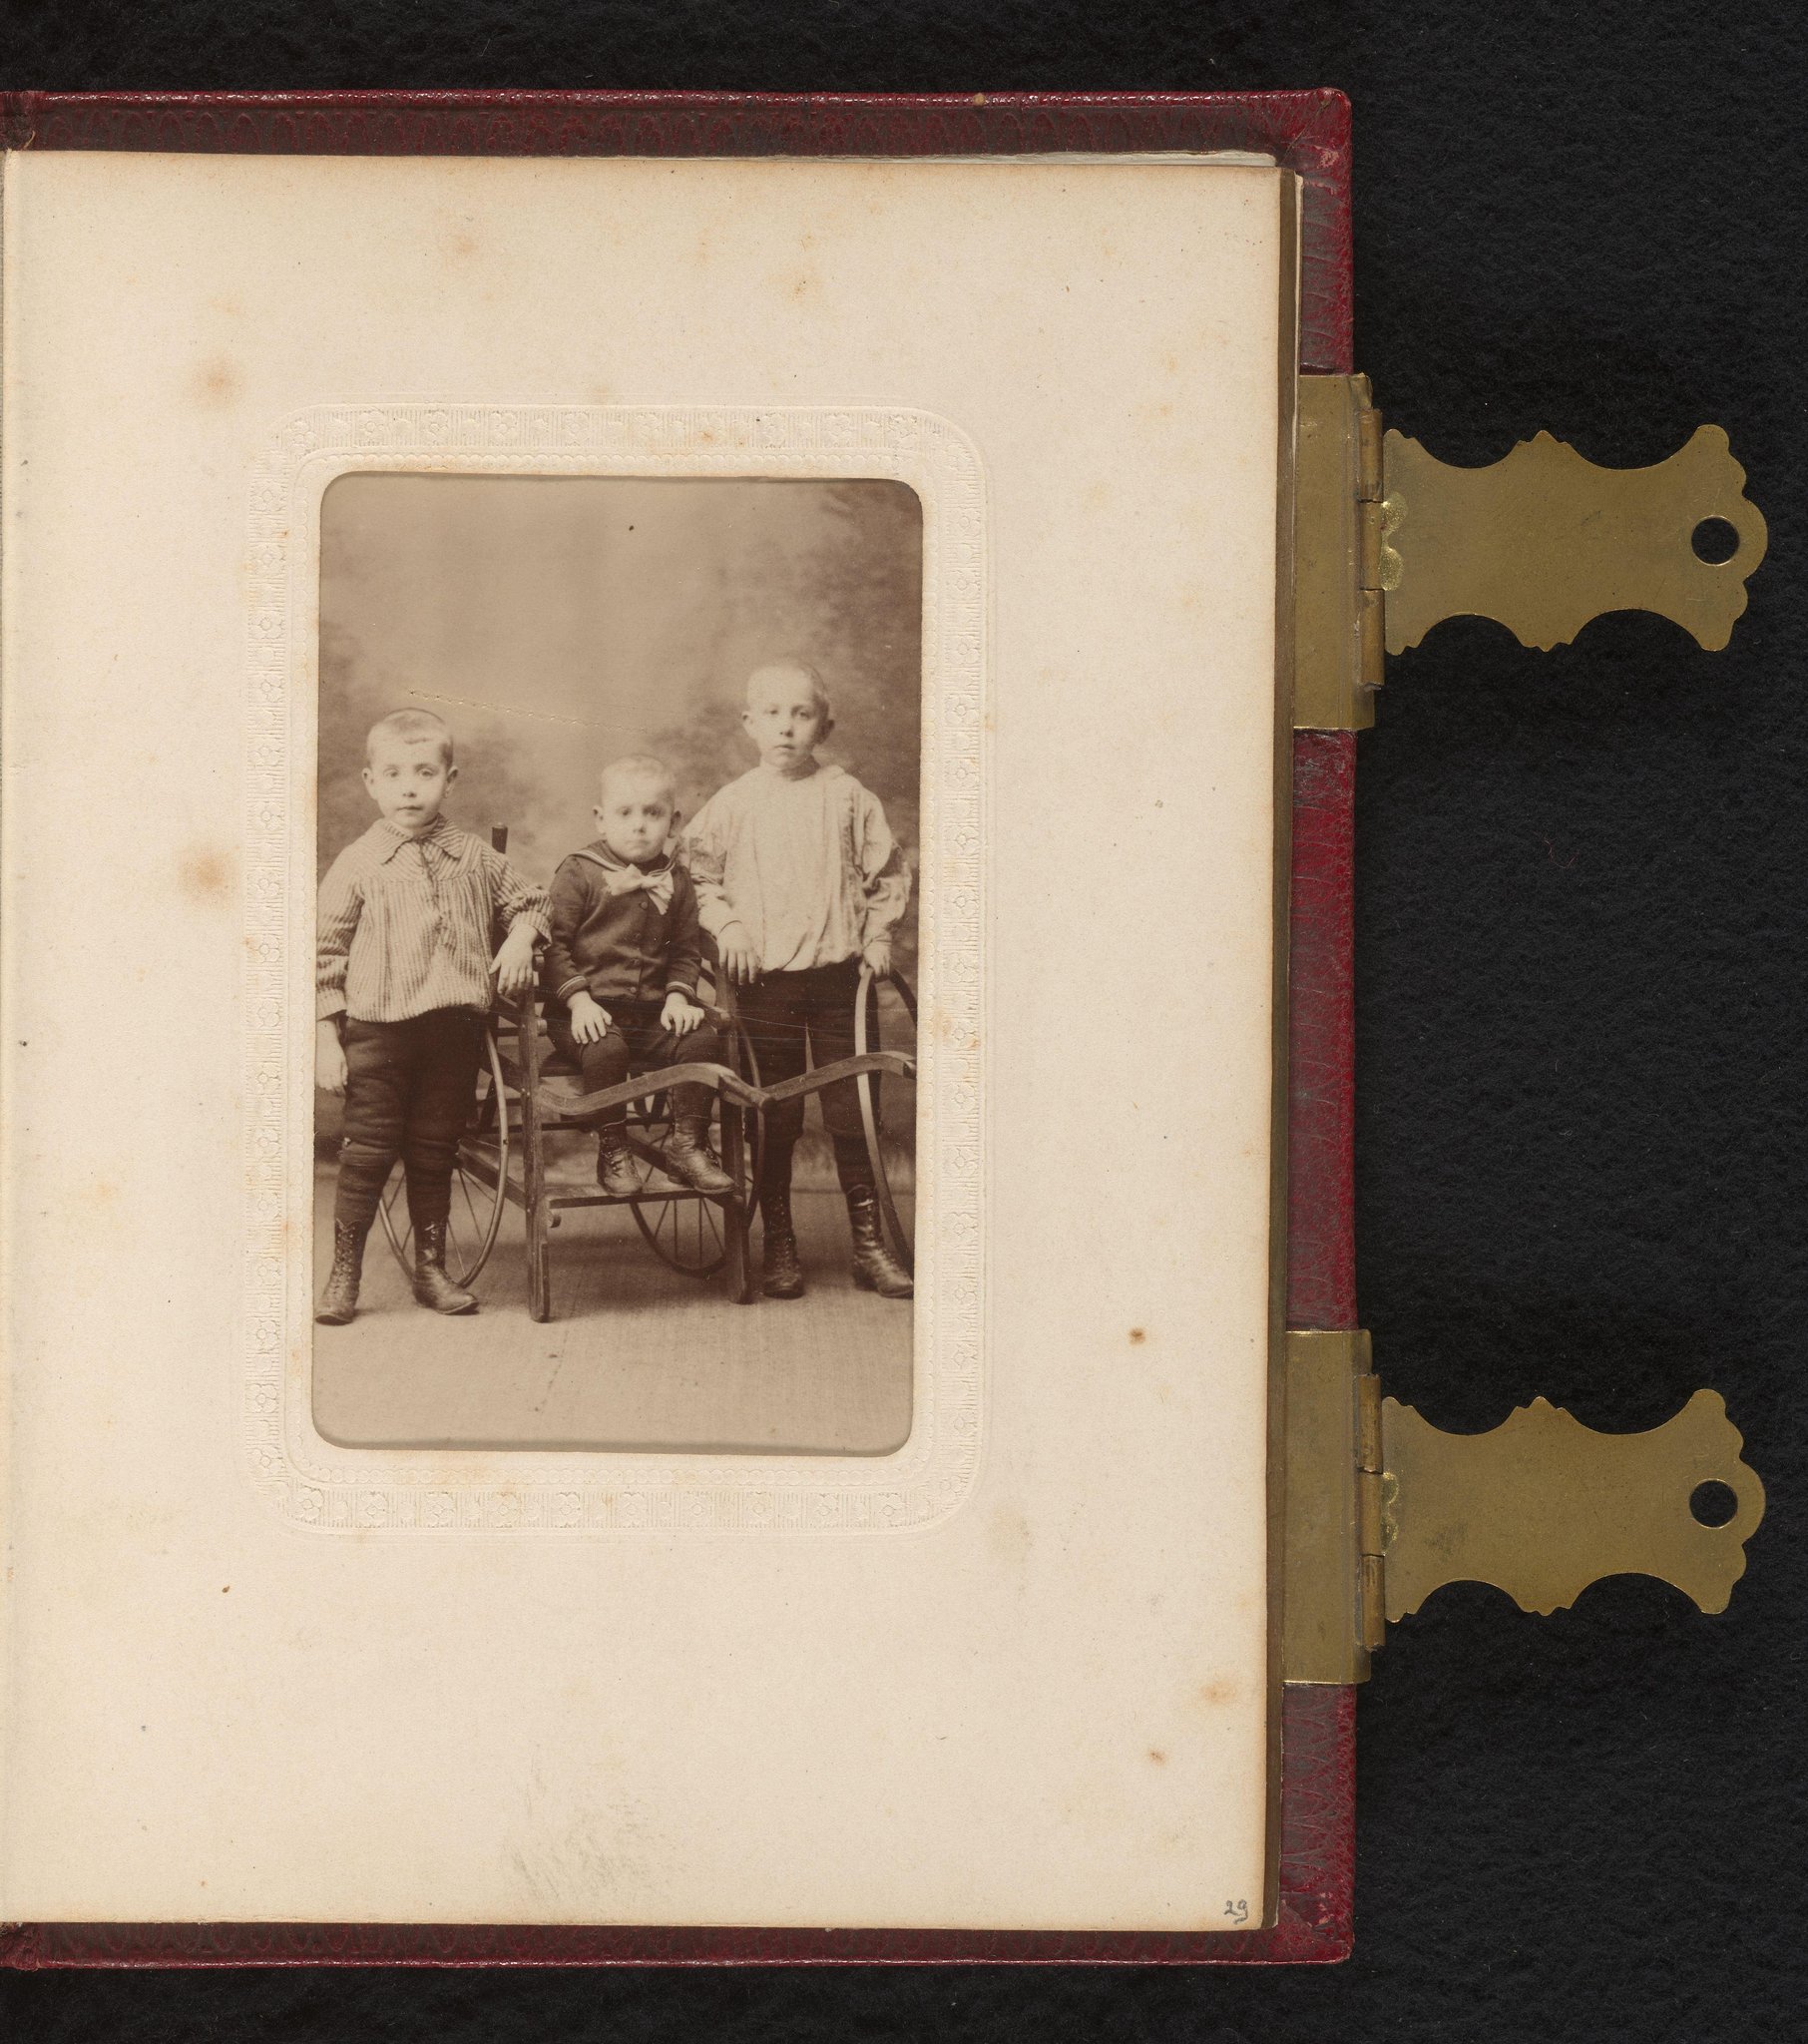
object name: photograph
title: Portret van drie kinderen, waarvan één zittend in een stoel met wielen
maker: Anonymous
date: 1860-1900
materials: cardboard, photographic support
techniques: albumen print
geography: netherlands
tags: child (+ three persons), anonymous historical persons portrayed in a group, in a group-portrait